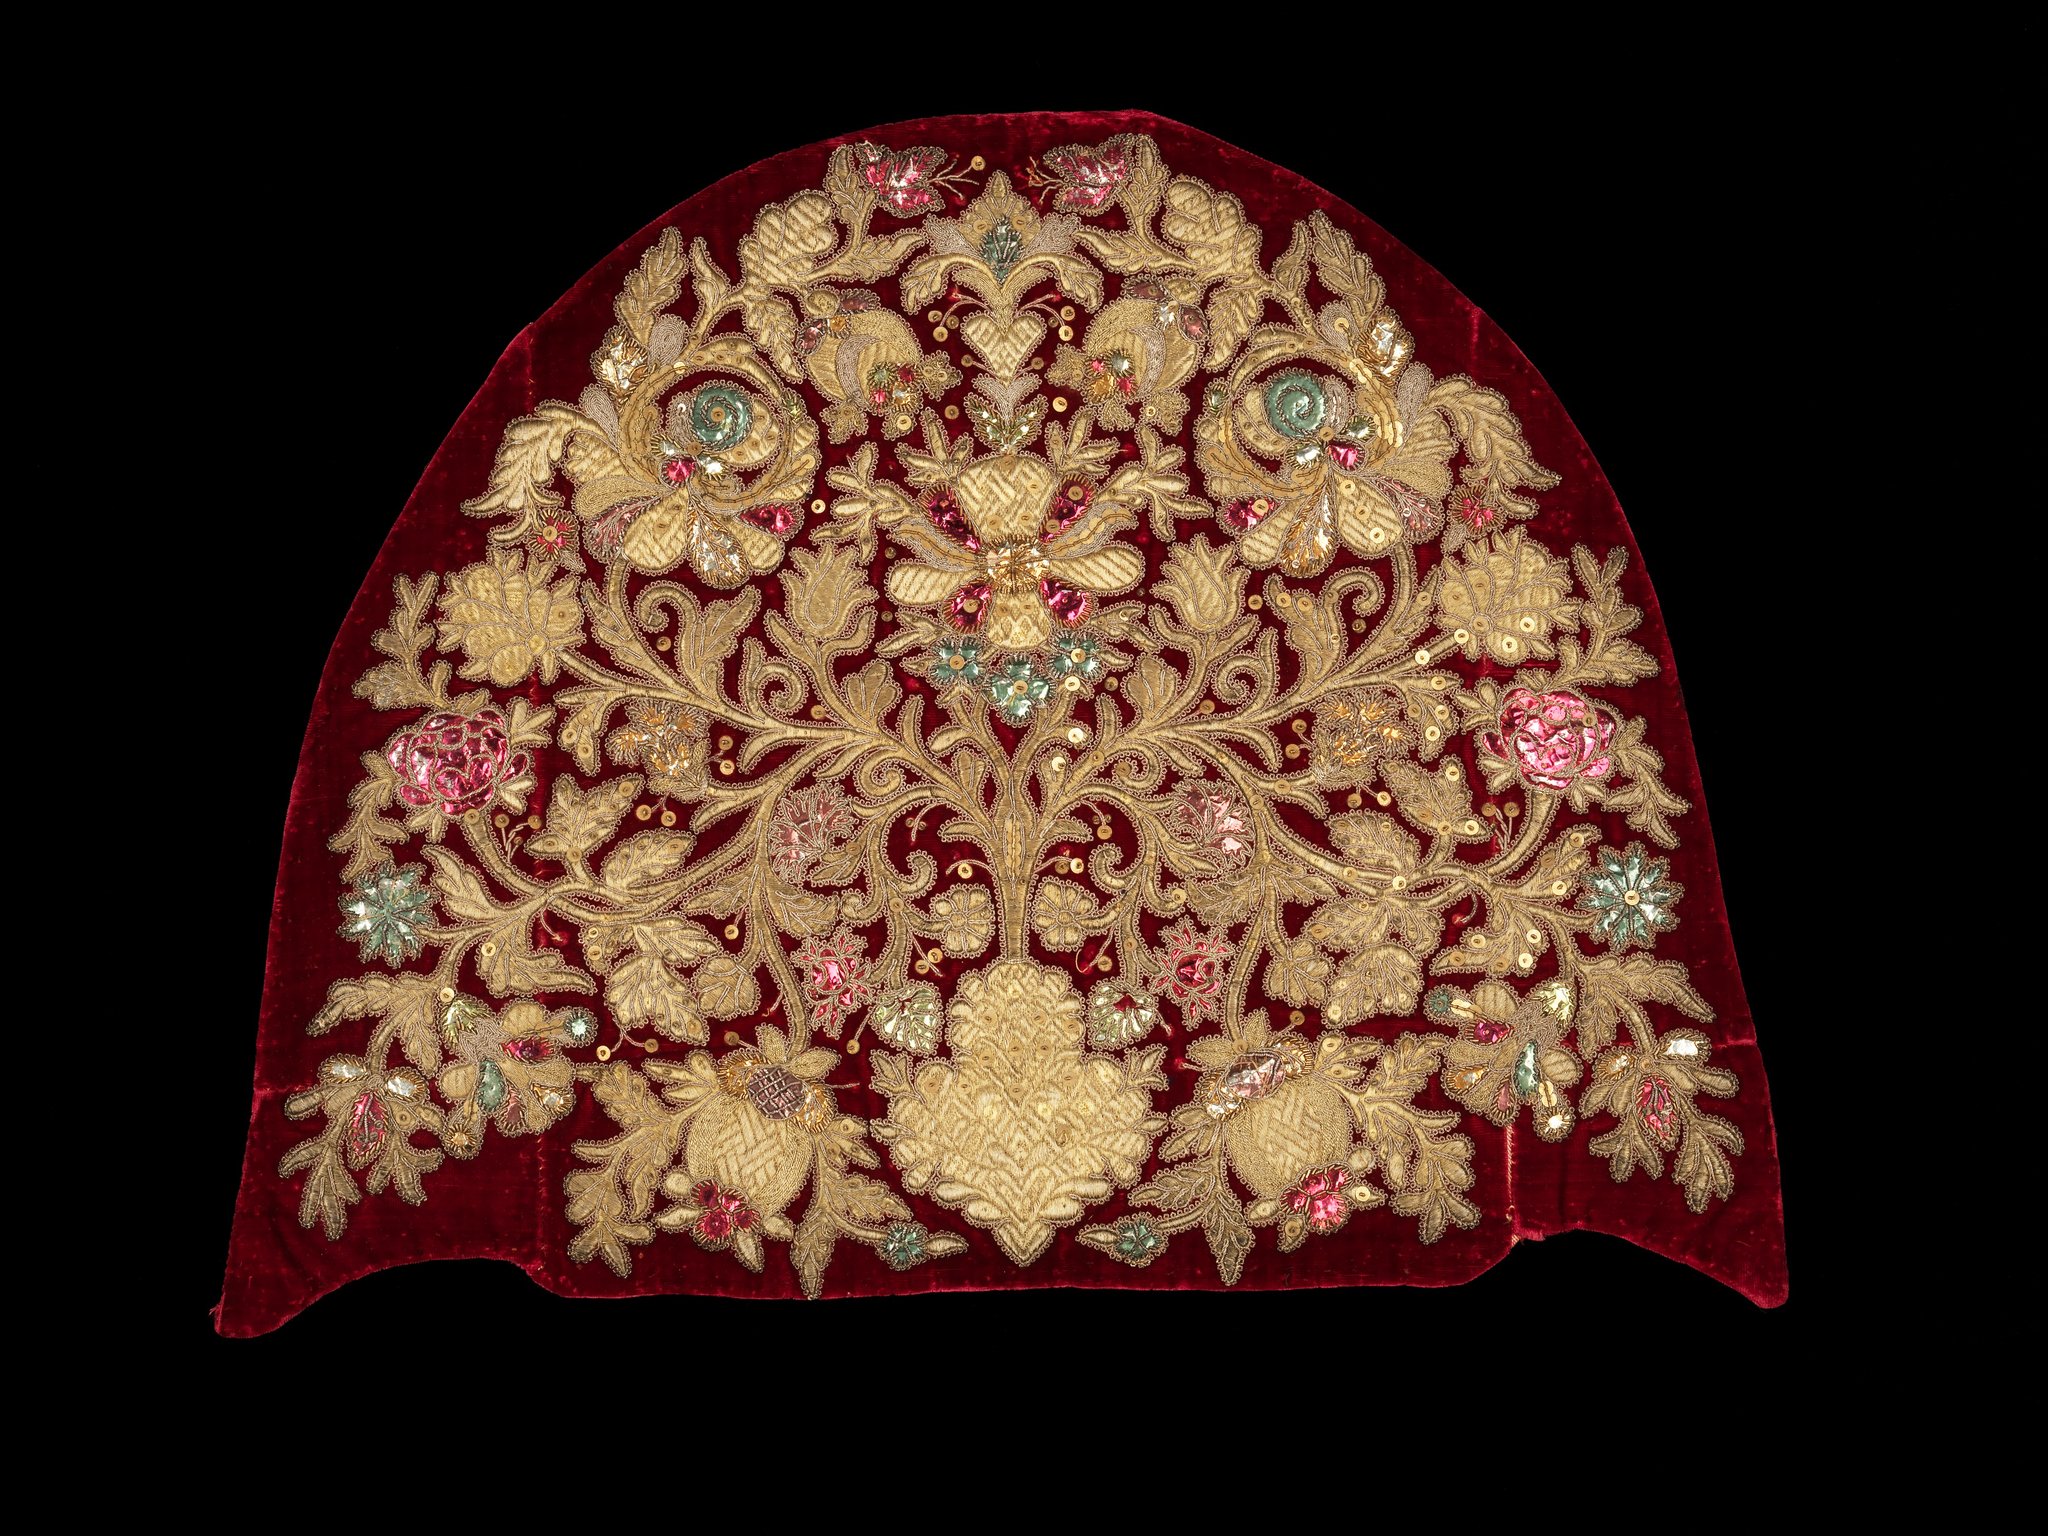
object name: headdress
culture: russian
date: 1776-1800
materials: linen, metal, silk